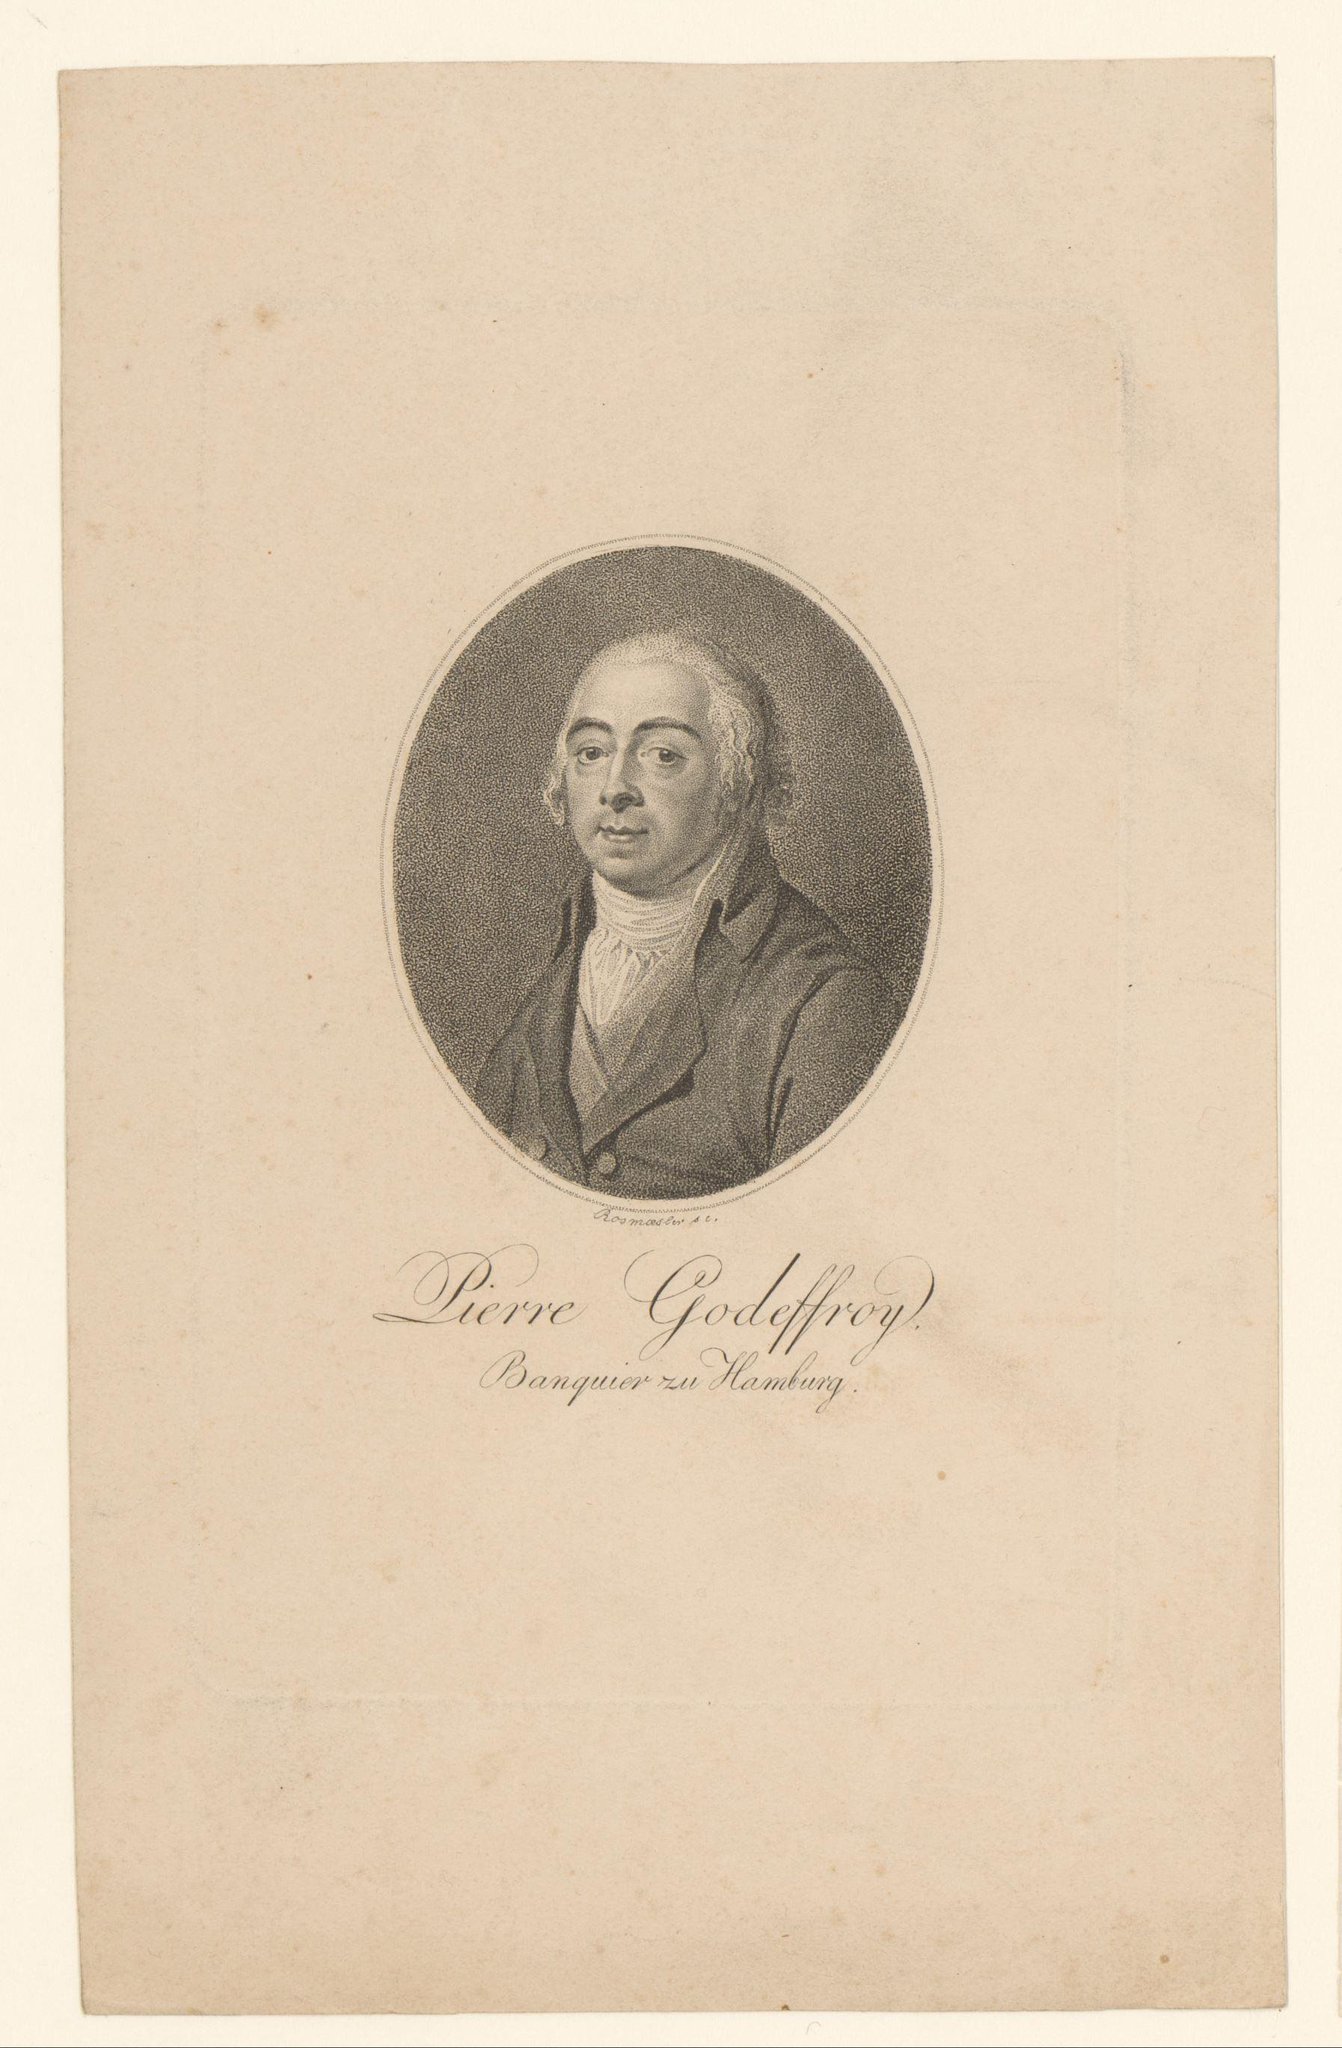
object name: print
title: Portret van Peter Godeffroy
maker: friedrich rossmässler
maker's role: print maker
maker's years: 1775-1858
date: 1785-1858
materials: paper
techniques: engraving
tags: historical persons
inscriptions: collector's mark: Lugt 2228